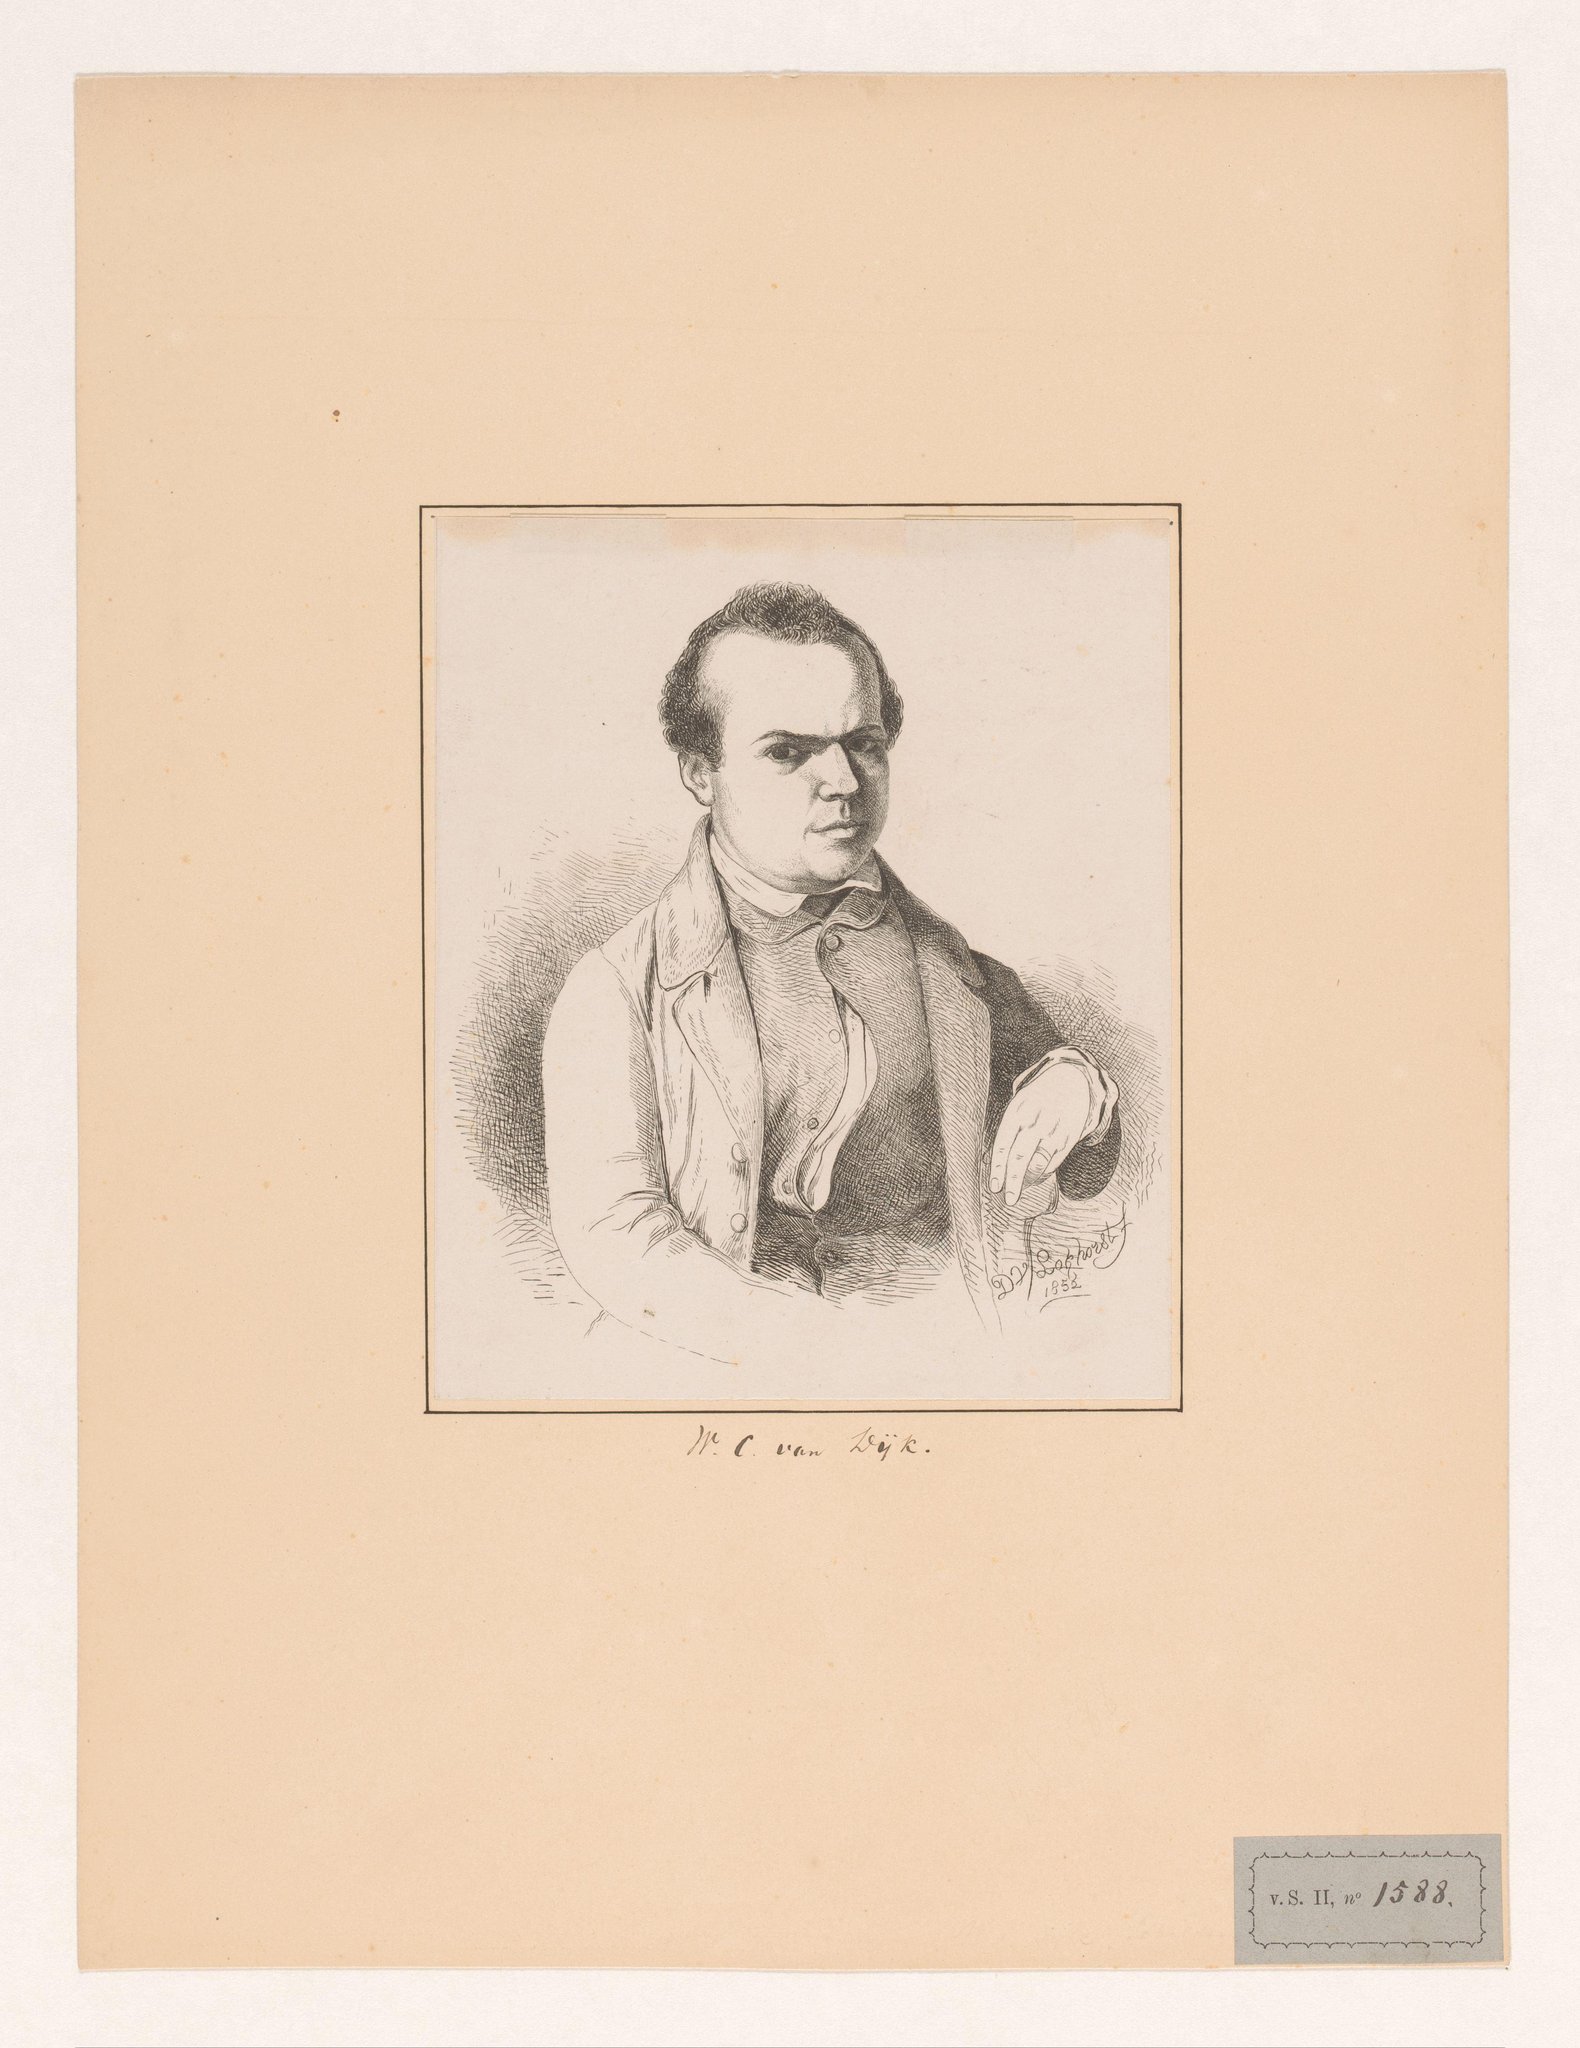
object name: print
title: Portret van Willem Cornelis van Dijk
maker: dirk van lokhorst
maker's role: draughtsman, painter, print maker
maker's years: 1818-1893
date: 1852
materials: paper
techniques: lithograph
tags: utrecht, amsterdam, painter, print maker, willem cornelis van dijk, historical persons (+ (full) bust portrait)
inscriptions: collector's mark: Lugt 2228